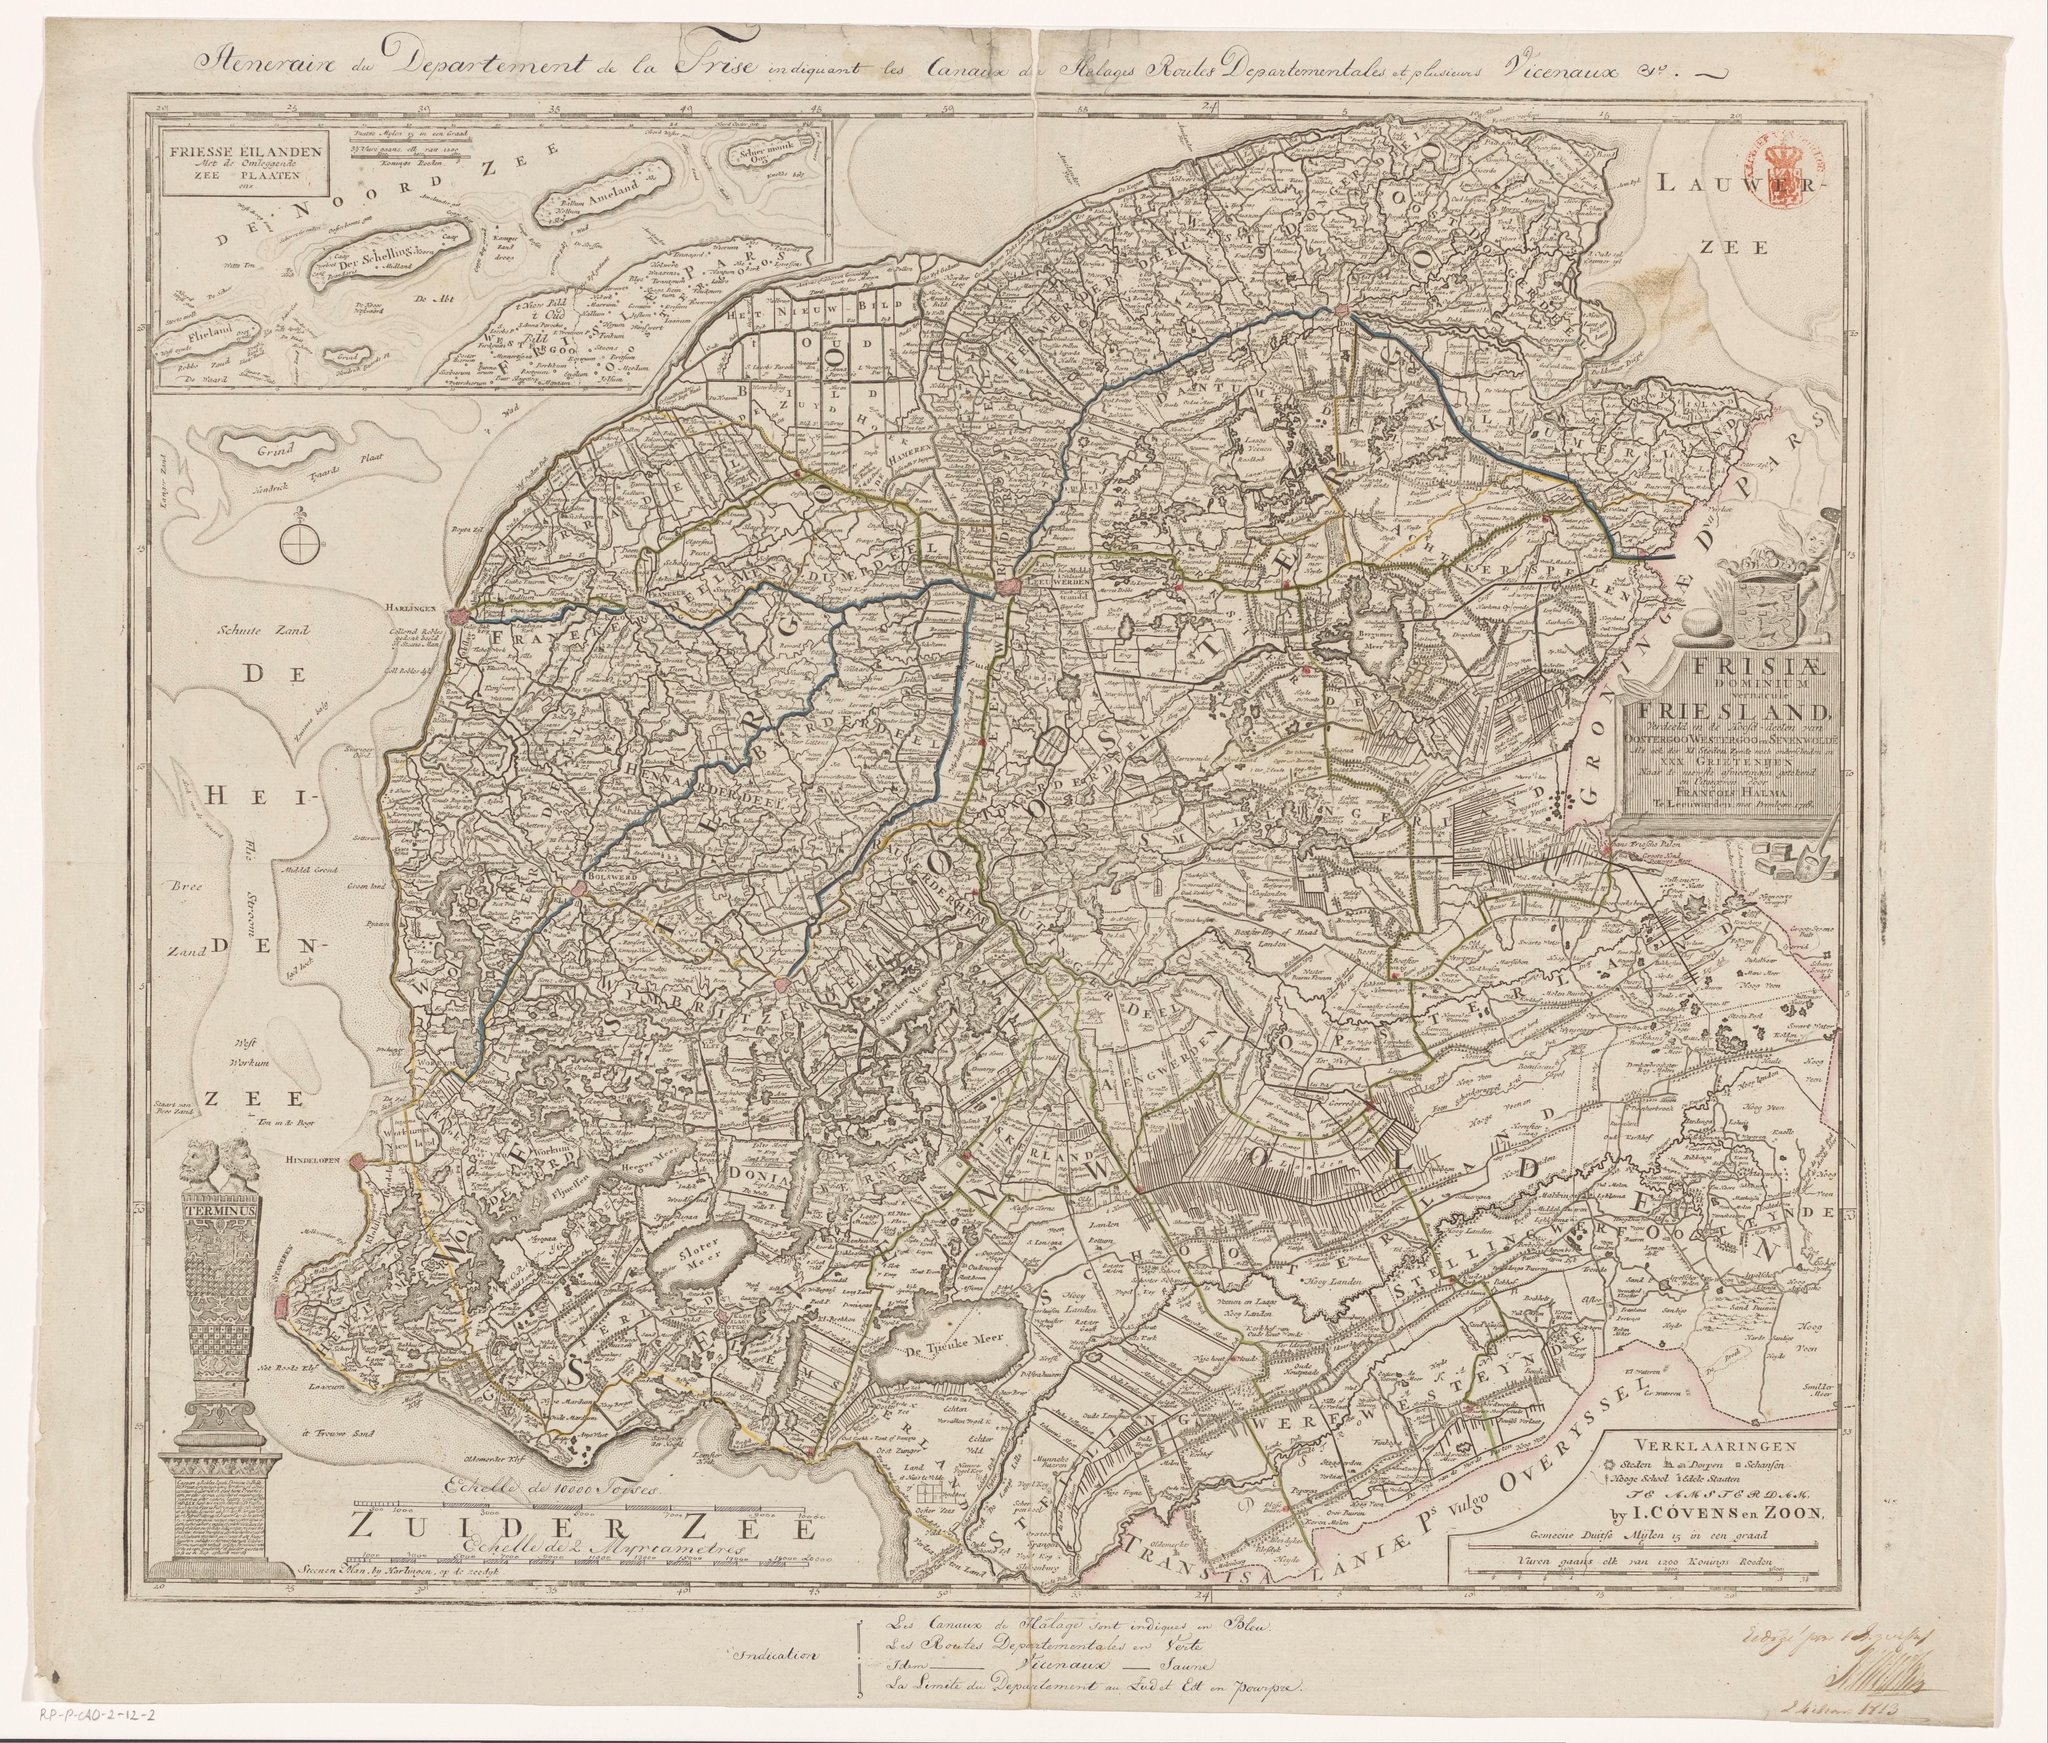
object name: print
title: Frisiae dominium vernacule Friesland (...)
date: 1787-1792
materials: paper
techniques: engraving, etching, hand coloring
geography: amsterdam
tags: coat of arms (as symbol of the state, etc.), maps of separate countries or regions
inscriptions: collector's mark: Lugt 19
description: Linksboven inzetkaart van Vlieland, Terschelling, Ameland en Schiermonnikoog, met twee schaalstokken: Duitze mijlen 15 in een graad, 3.25 uure gaans elk van 1200 konings roeden. Linksonder afbeelding van het standbeeld de Stenen Man te Harlingen. Rechtsmidden titelcartouche met daarboven het wapen van Friesland. Rechtsonder legenda en twee schaalstokken: Gemeene Duitse mijlen 15 in een graad, Uuren gaans elk van 1200 konings roeden. Gradenverdeling langs de randen.